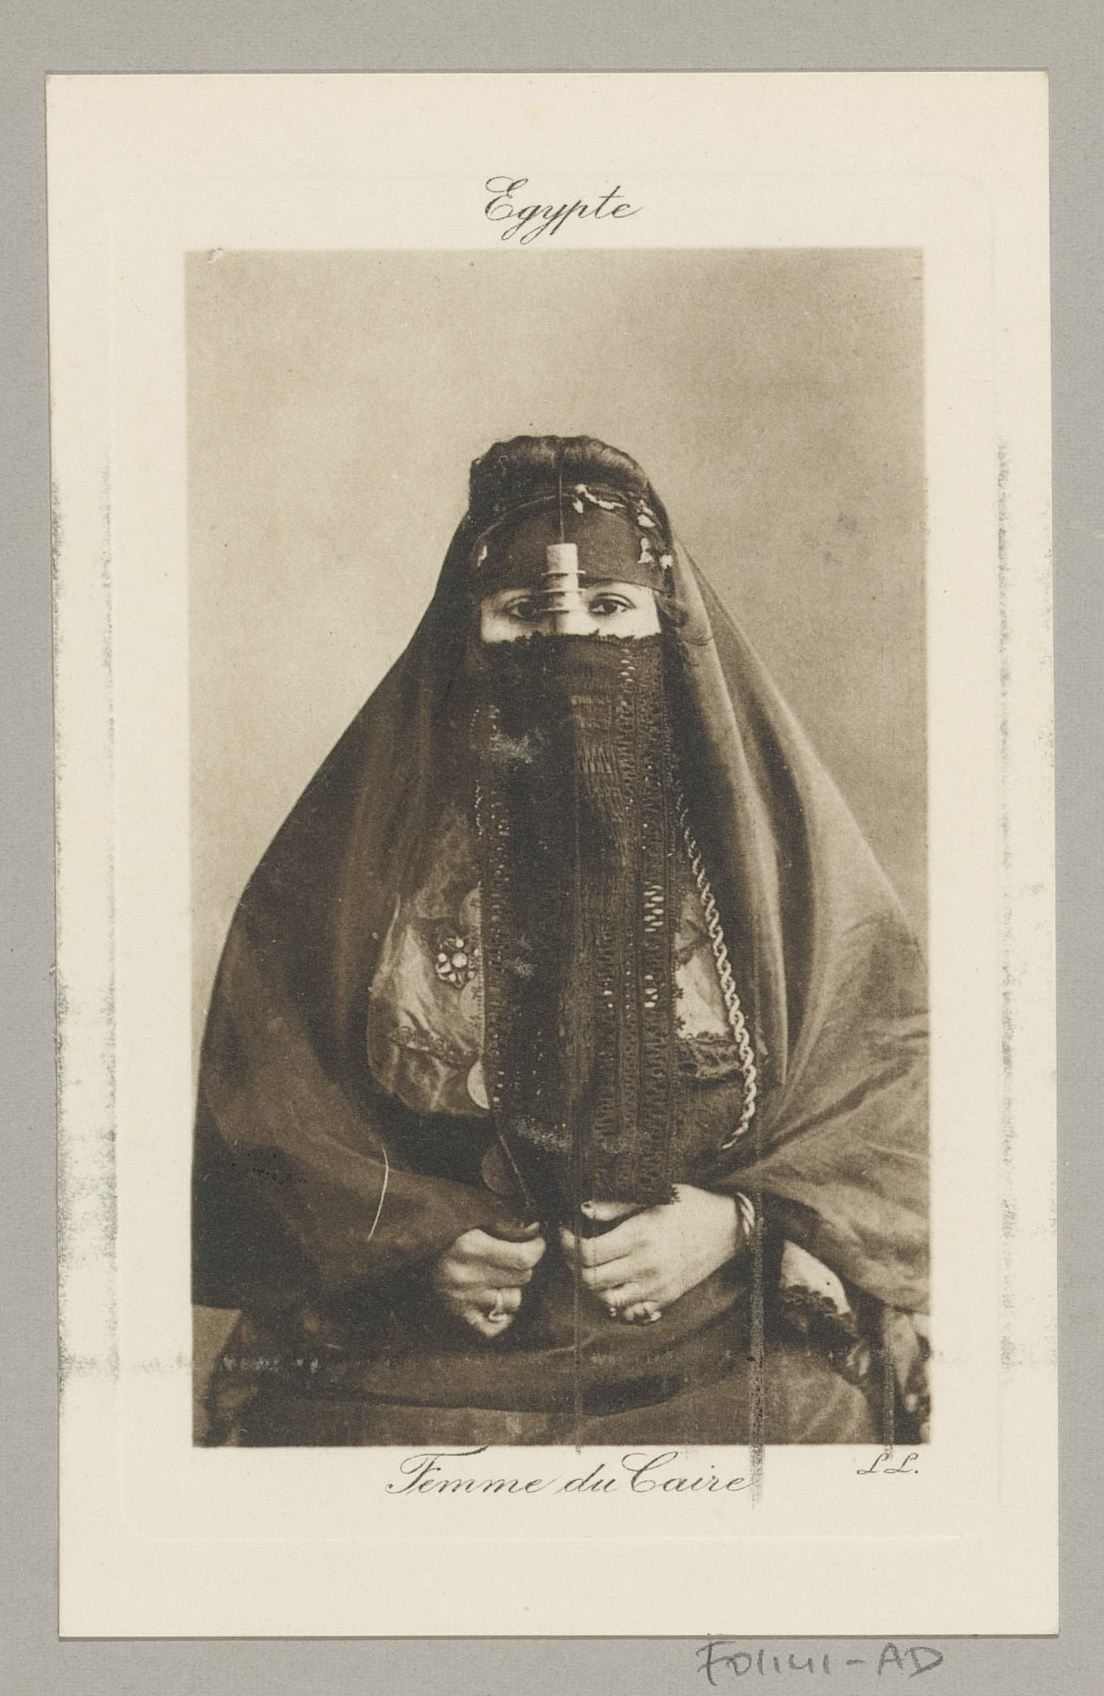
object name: photomechanical print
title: Egypte, Femme du Caire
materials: paper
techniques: photograph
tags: adult woman, head-gear (with name)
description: Onderdeel van Fotoalbum van een reis door Zuid-Europa en het Midden-Oosten.